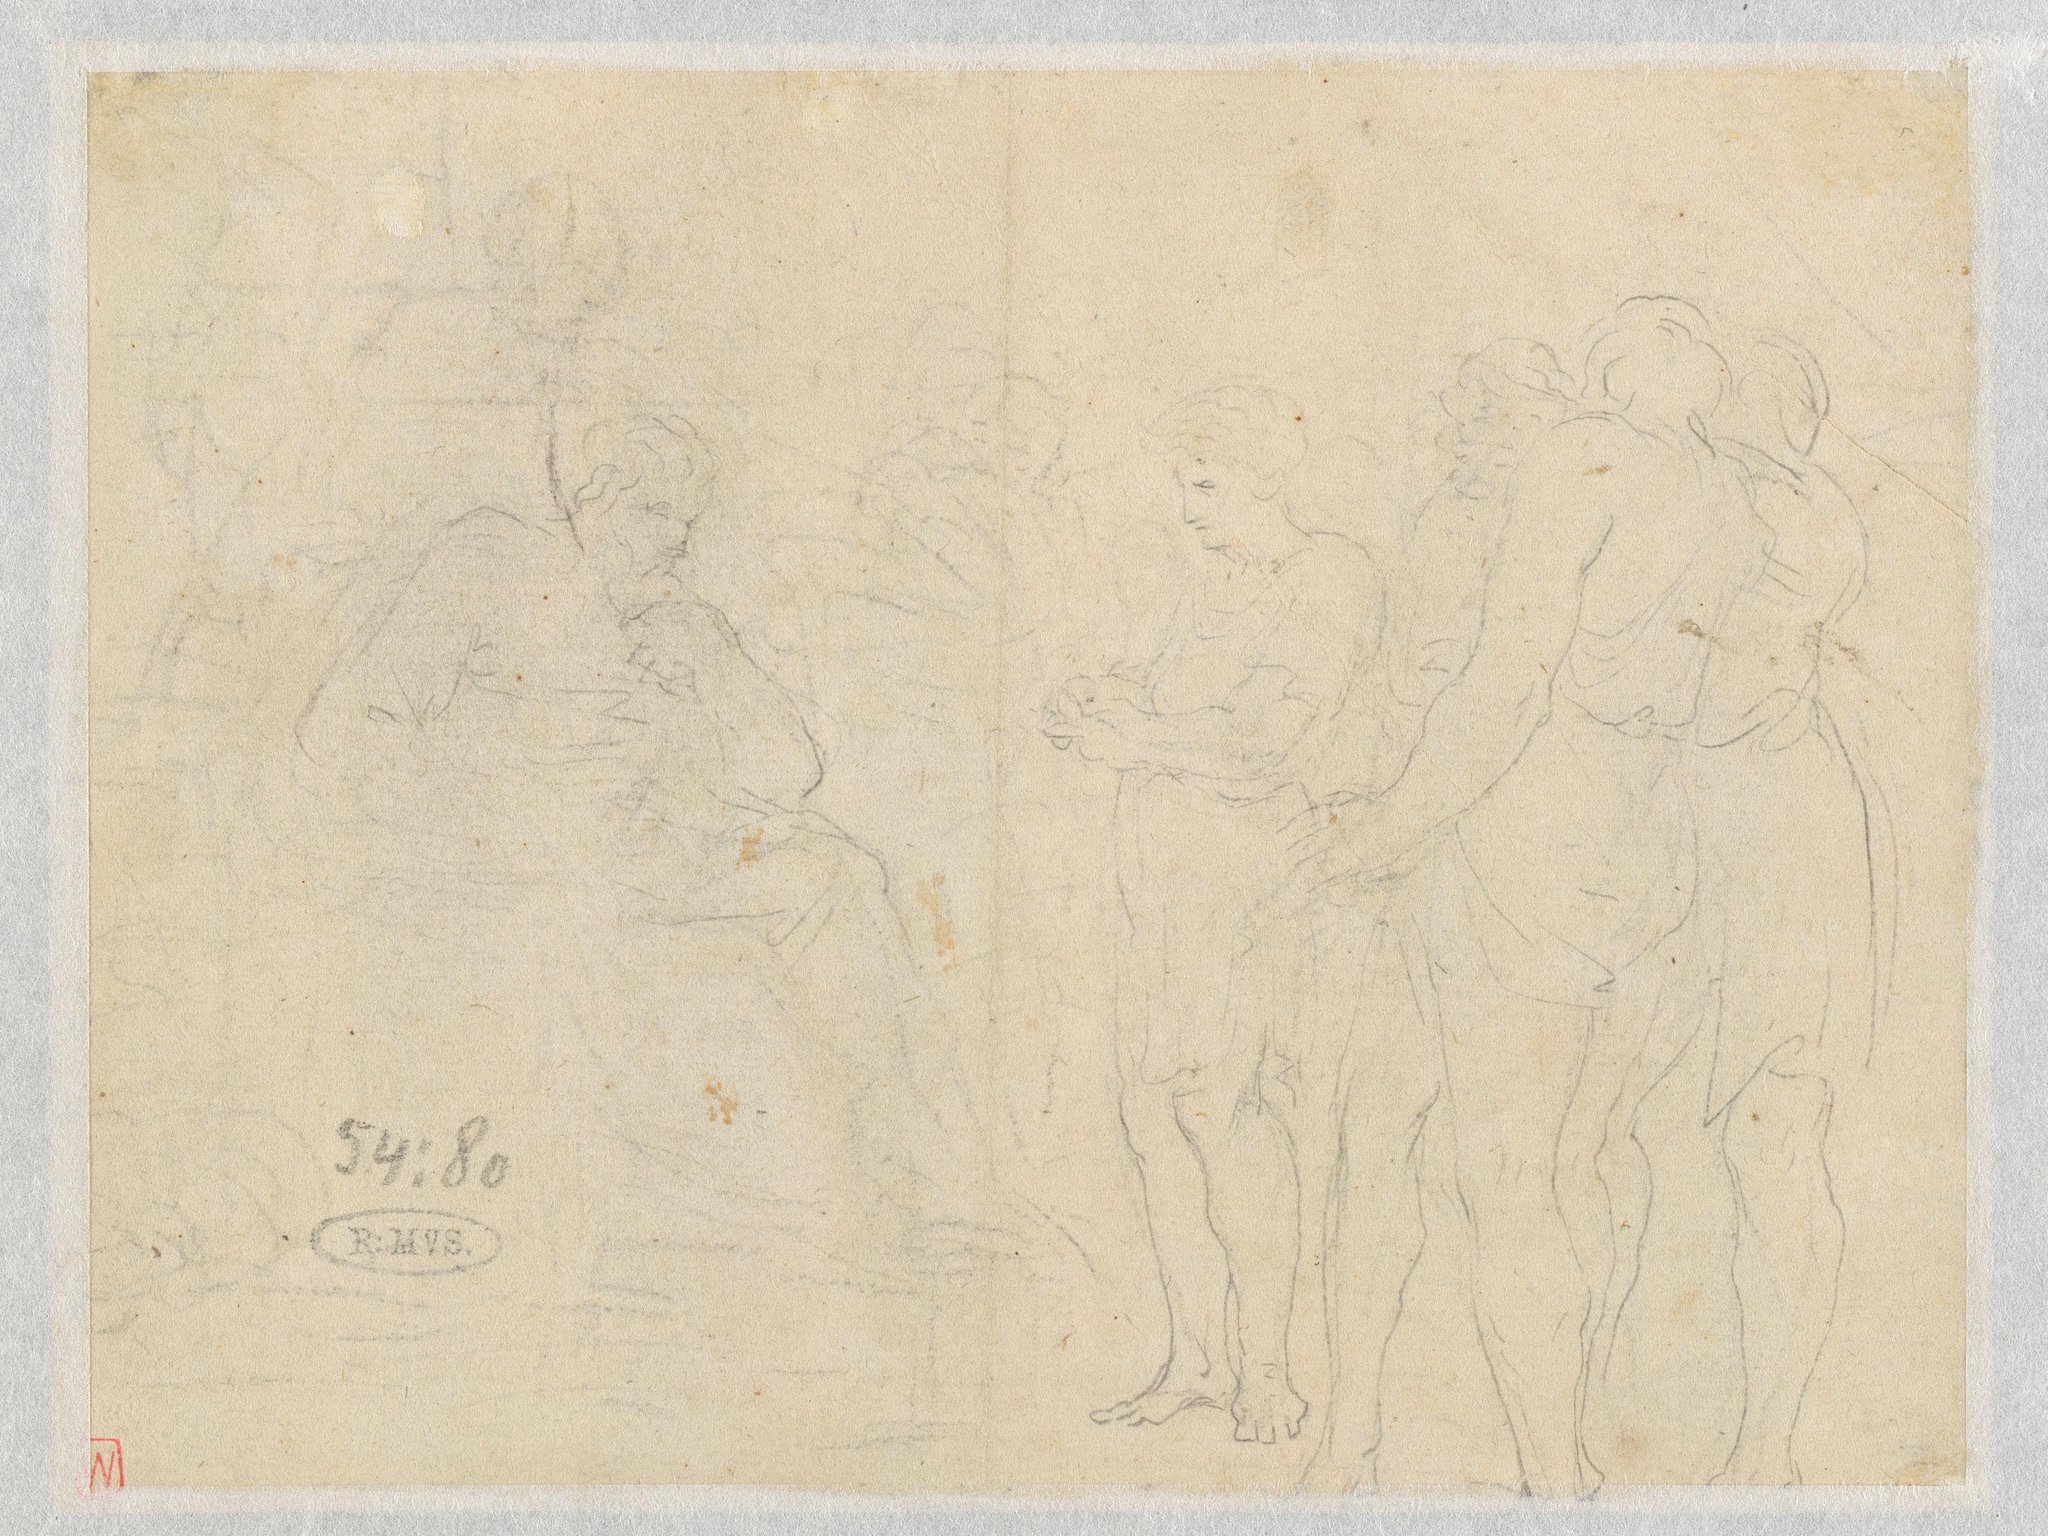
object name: drawing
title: Vier staande mannen voor een zittende man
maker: salomon de bray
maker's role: draughtsman, print maker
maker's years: 1597-1664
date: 1607-1664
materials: paper, pencil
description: Links zit een man, rechts voor hem vier staande mannen. Wellicht een uitbeelding van de parabel van de wijngaarde.